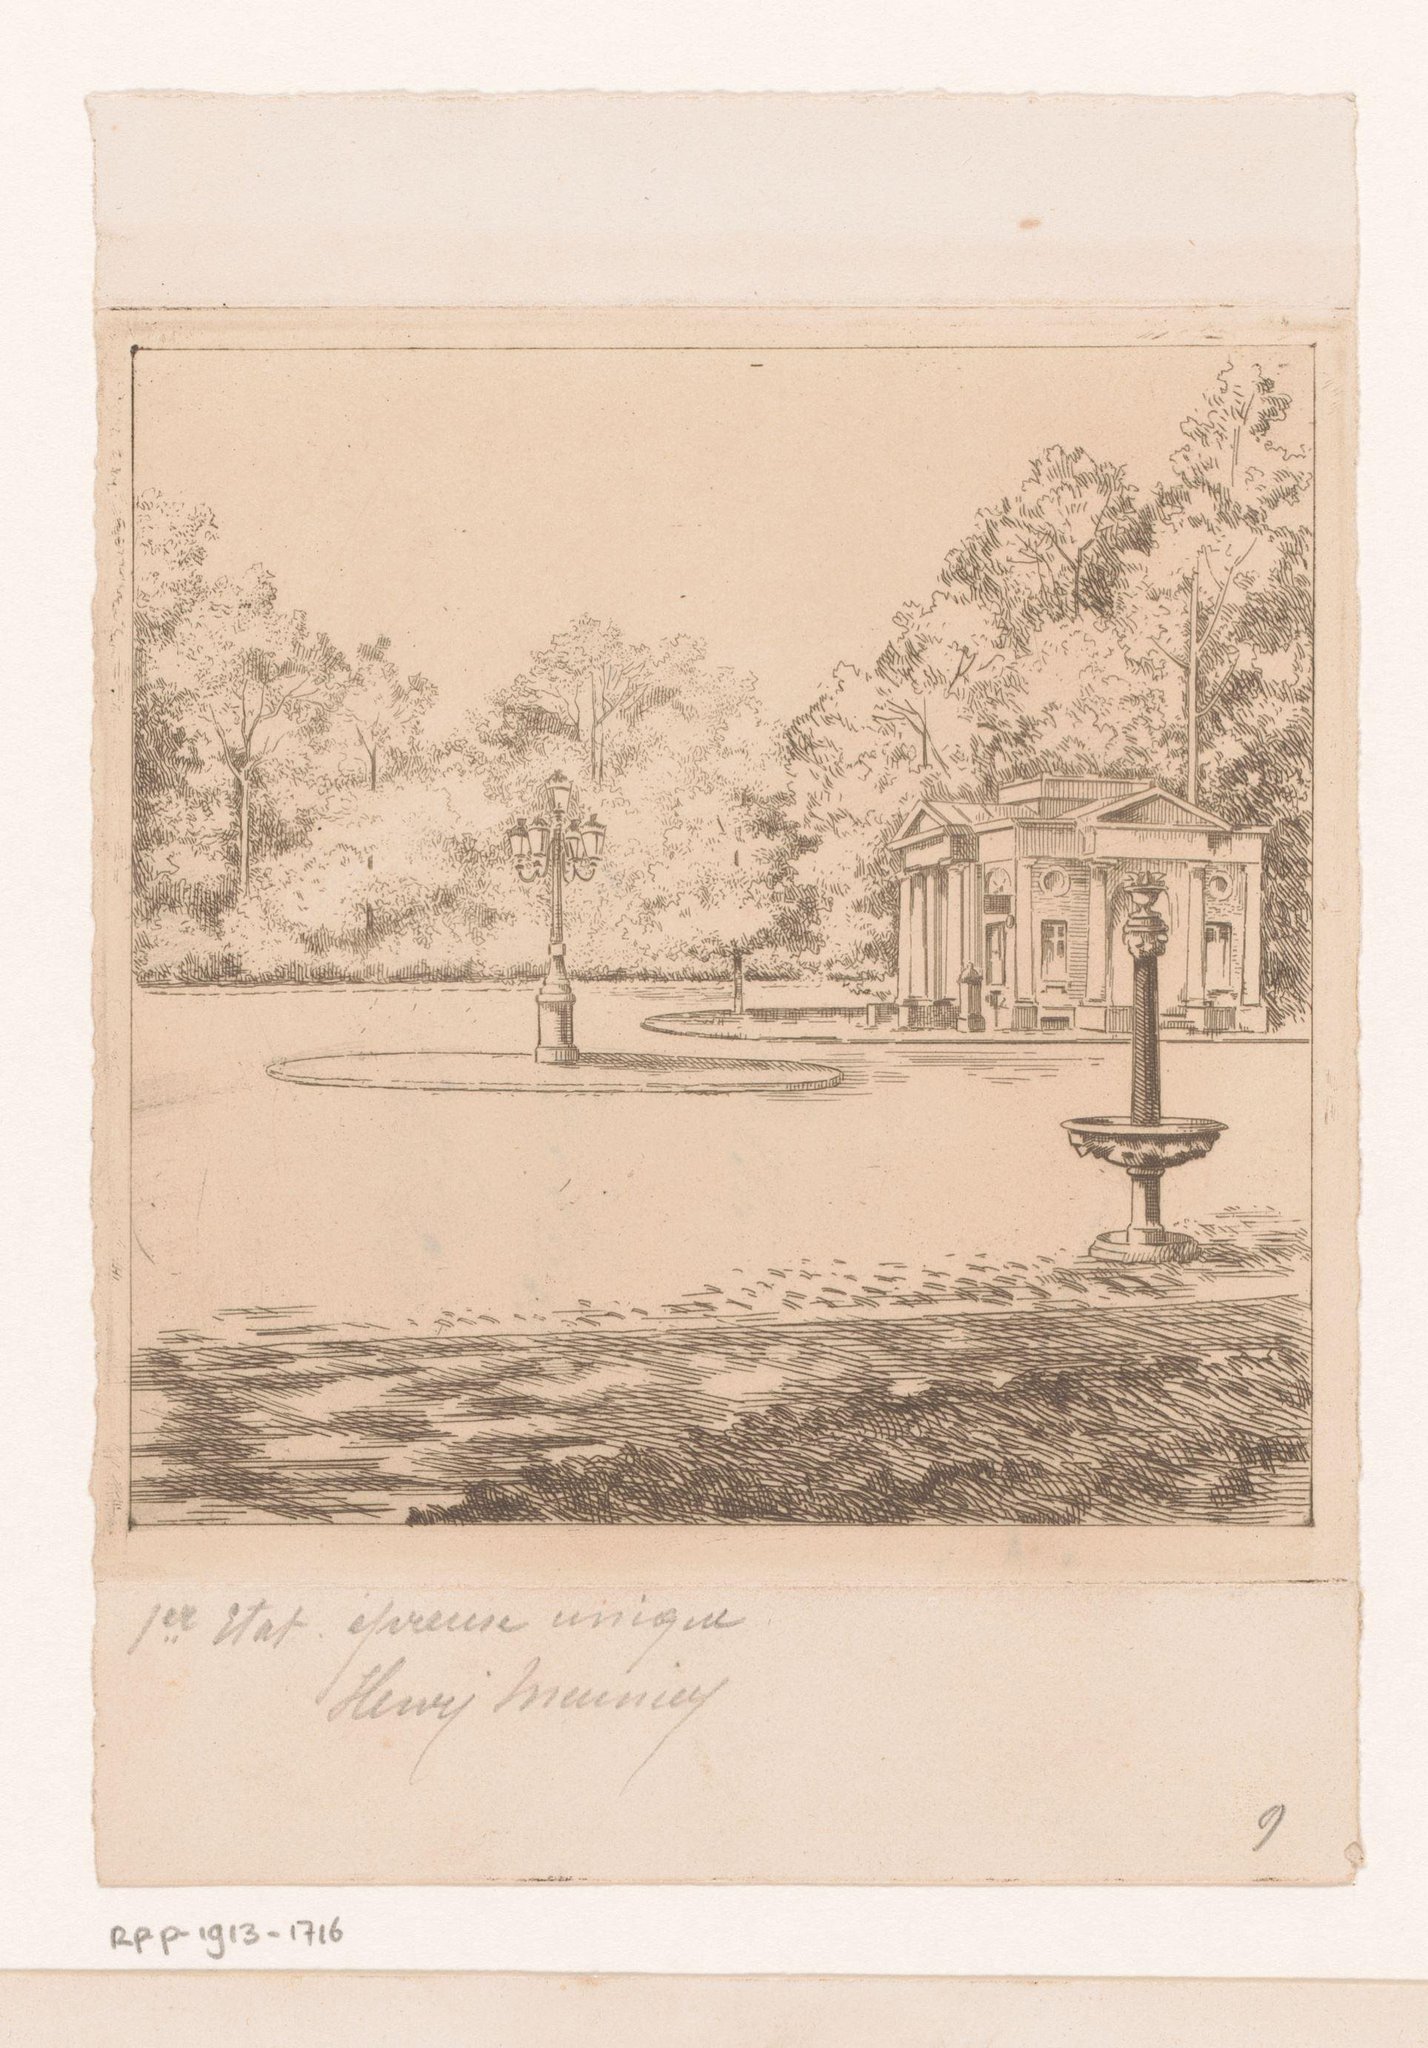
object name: print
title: Ingang van het Ter Kamerenbos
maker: marc henry meunier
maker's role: print maker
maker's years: 1873-1922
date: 1883-1913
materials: paper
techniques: etching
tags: garden buildings, street lighting, public gardens, park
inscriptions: inscription: ‘1er Etat épreuve unique’, collector's mark: Lugt 2228, inscription